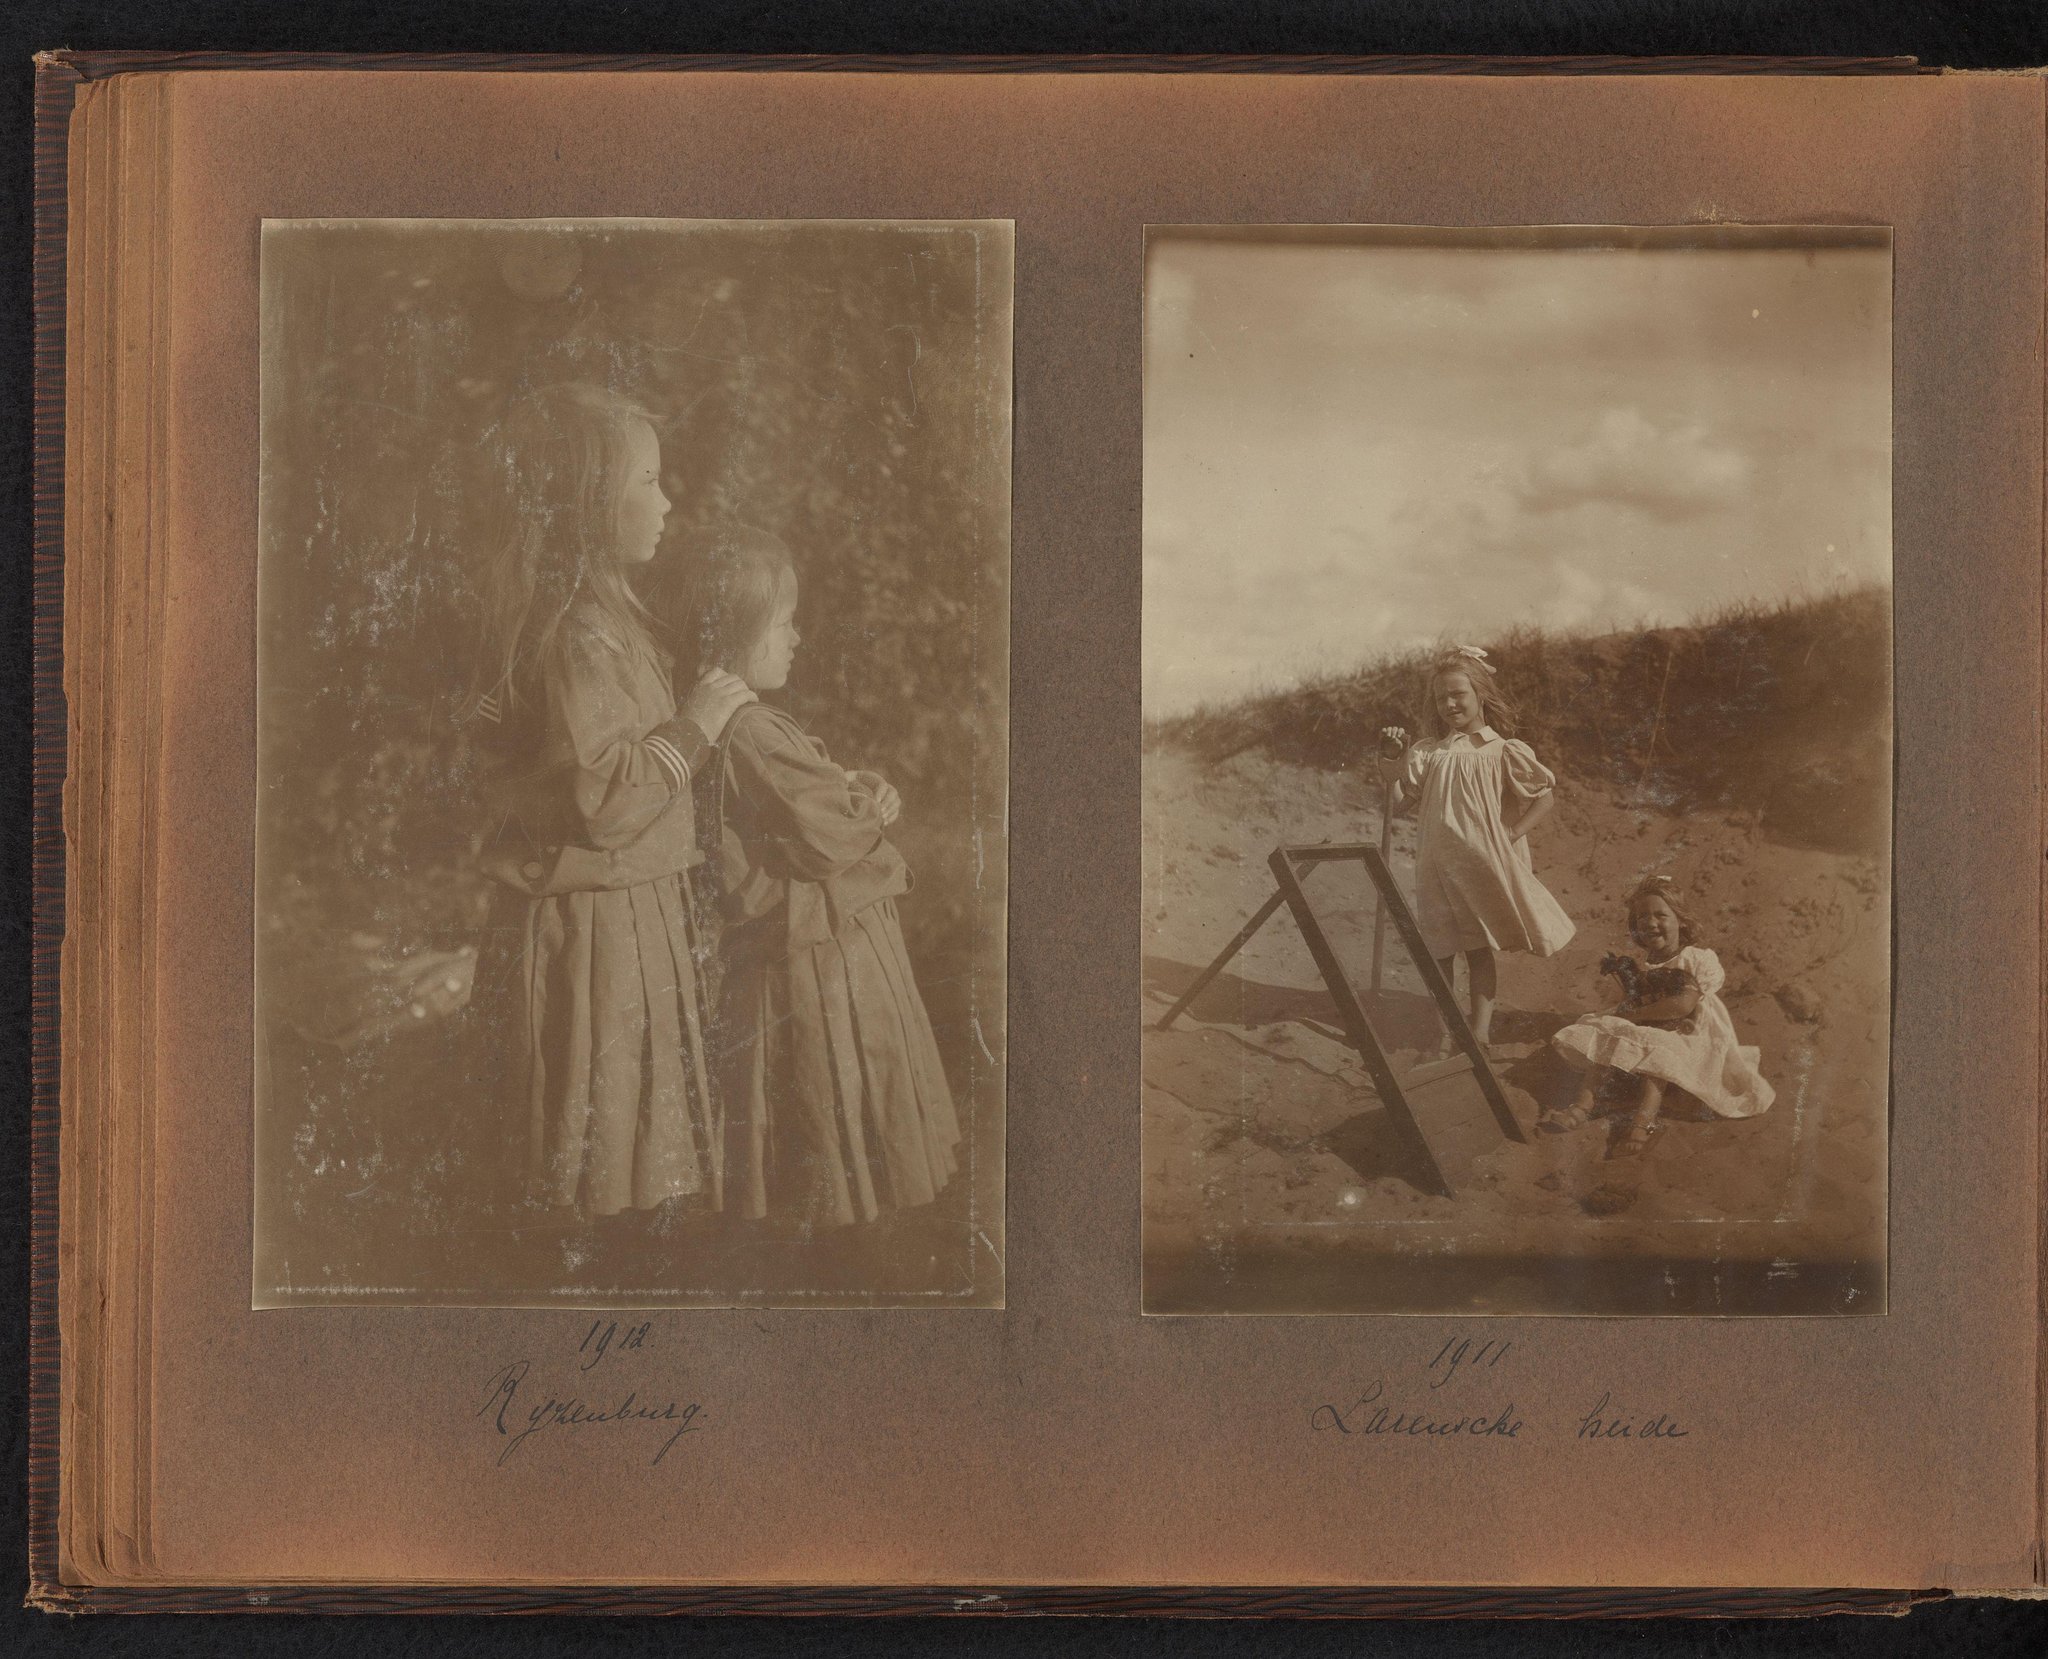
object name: album leaf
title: Bladzijde uit het fotoalbum van de familie Diepenbrock met 2 foto's van de dochters van Alphons Diepenbrock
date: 1911-1912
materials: cardboard, photographic support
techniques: photography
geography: amsterdam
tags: amsterdam, netherlands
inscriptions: inscription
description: Bruin albumblad 18 van familiealbum van Alphons Diepenbrock.